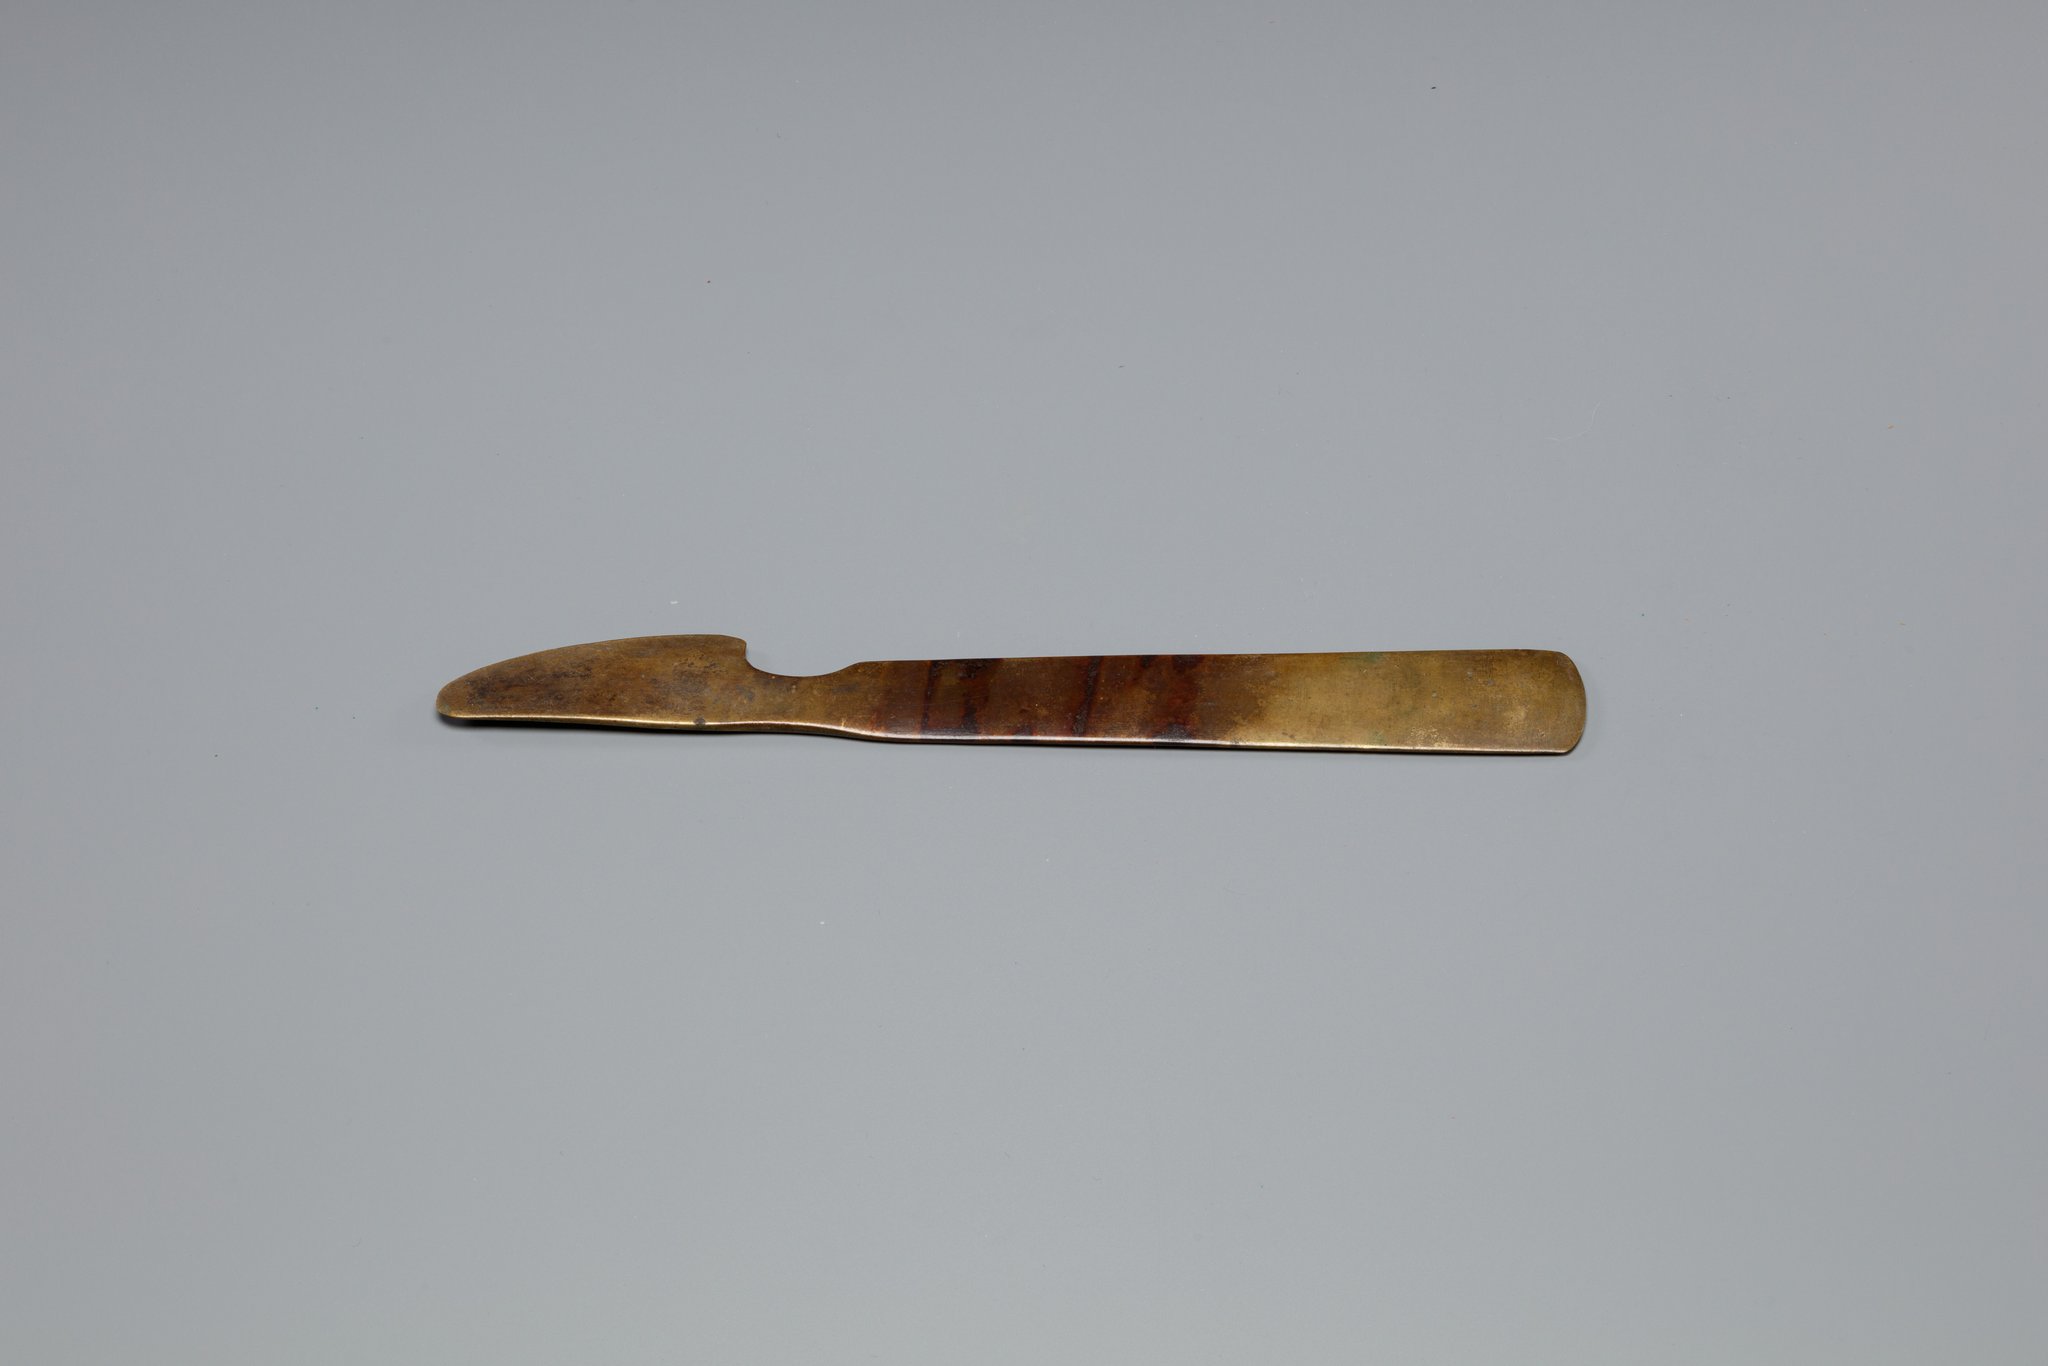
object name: razor knife, dega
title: Knife Razor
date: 1550-1295 BCE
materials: bronze, textile, copper alloy, stone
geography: egypt